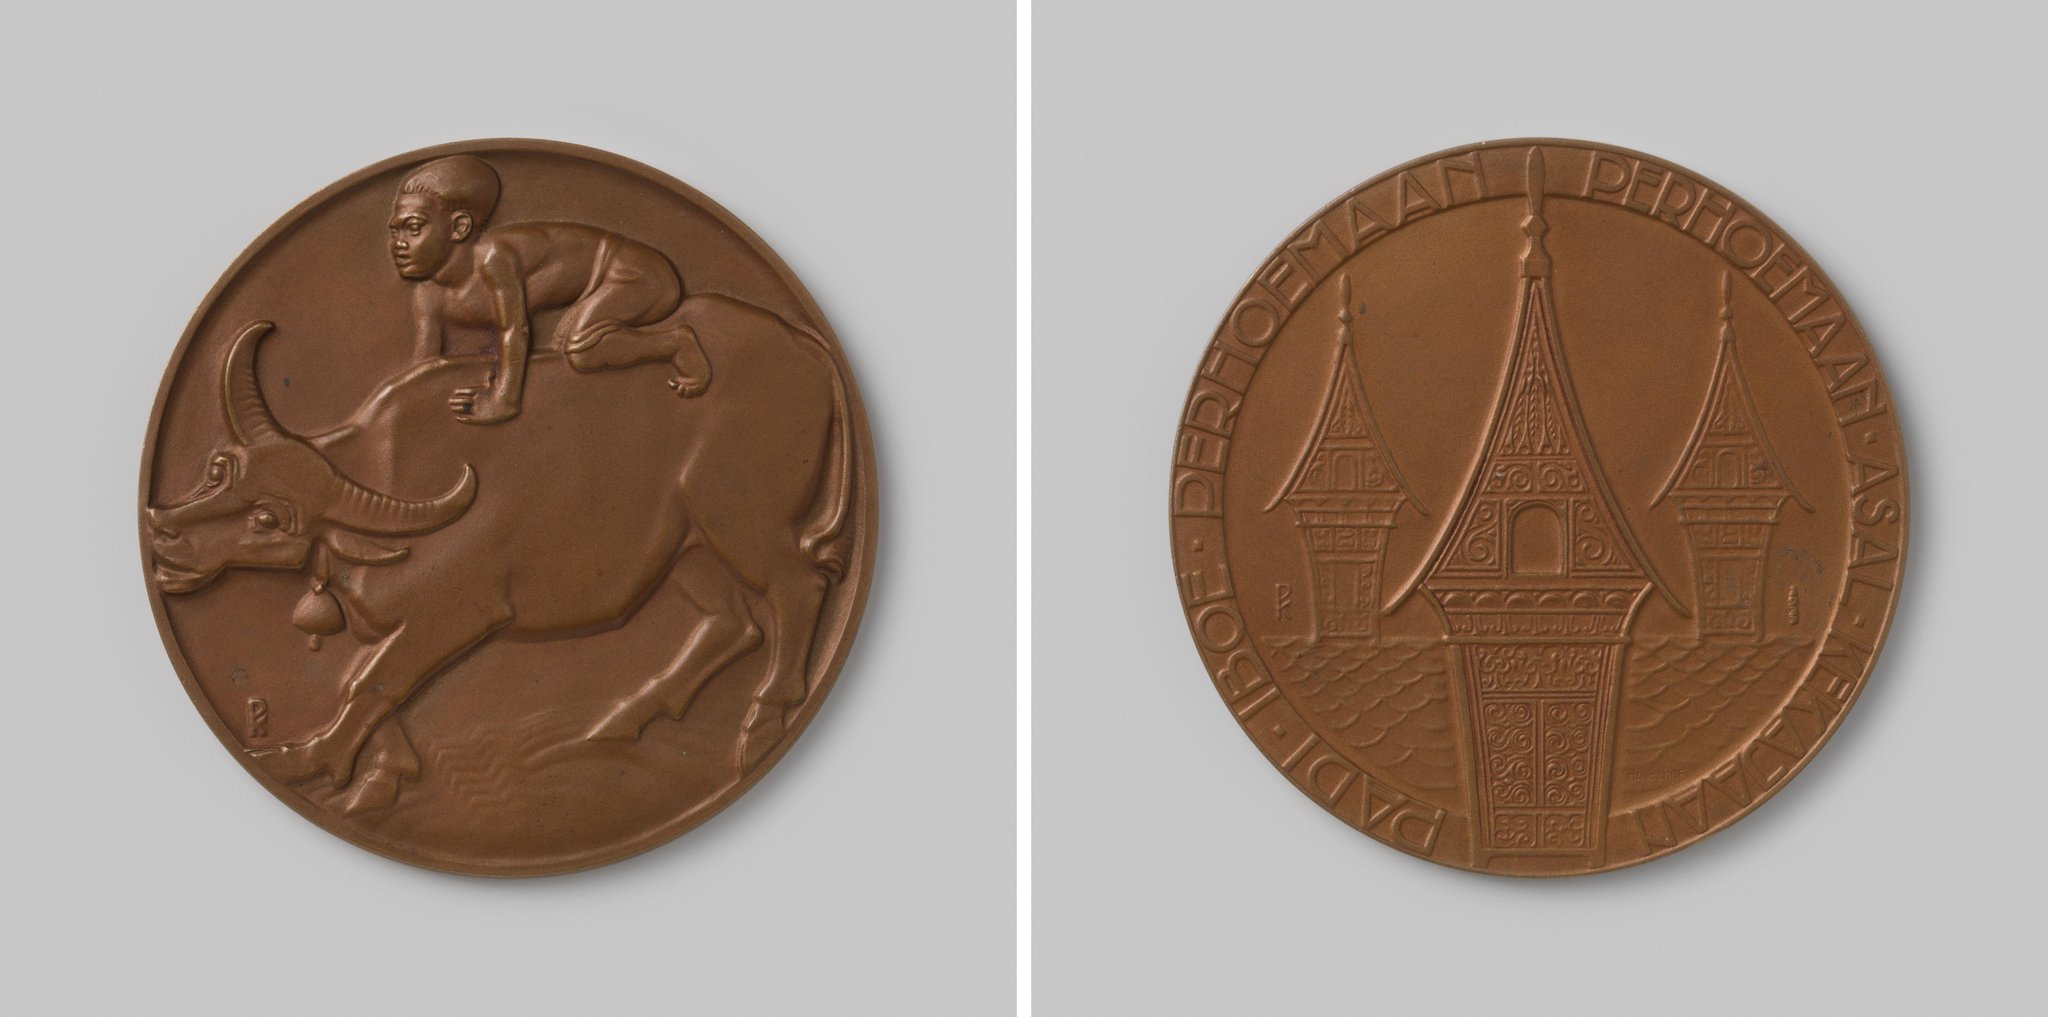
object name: history medal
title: Landbouw in Nederlands-Indië (Vereniging voor Penningkunst 1933, tweede penning)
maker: h.a. van derse ende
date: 1933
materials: bronze, cardboard, velvet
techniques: striking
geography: voorschoten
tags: dutch east indies, the